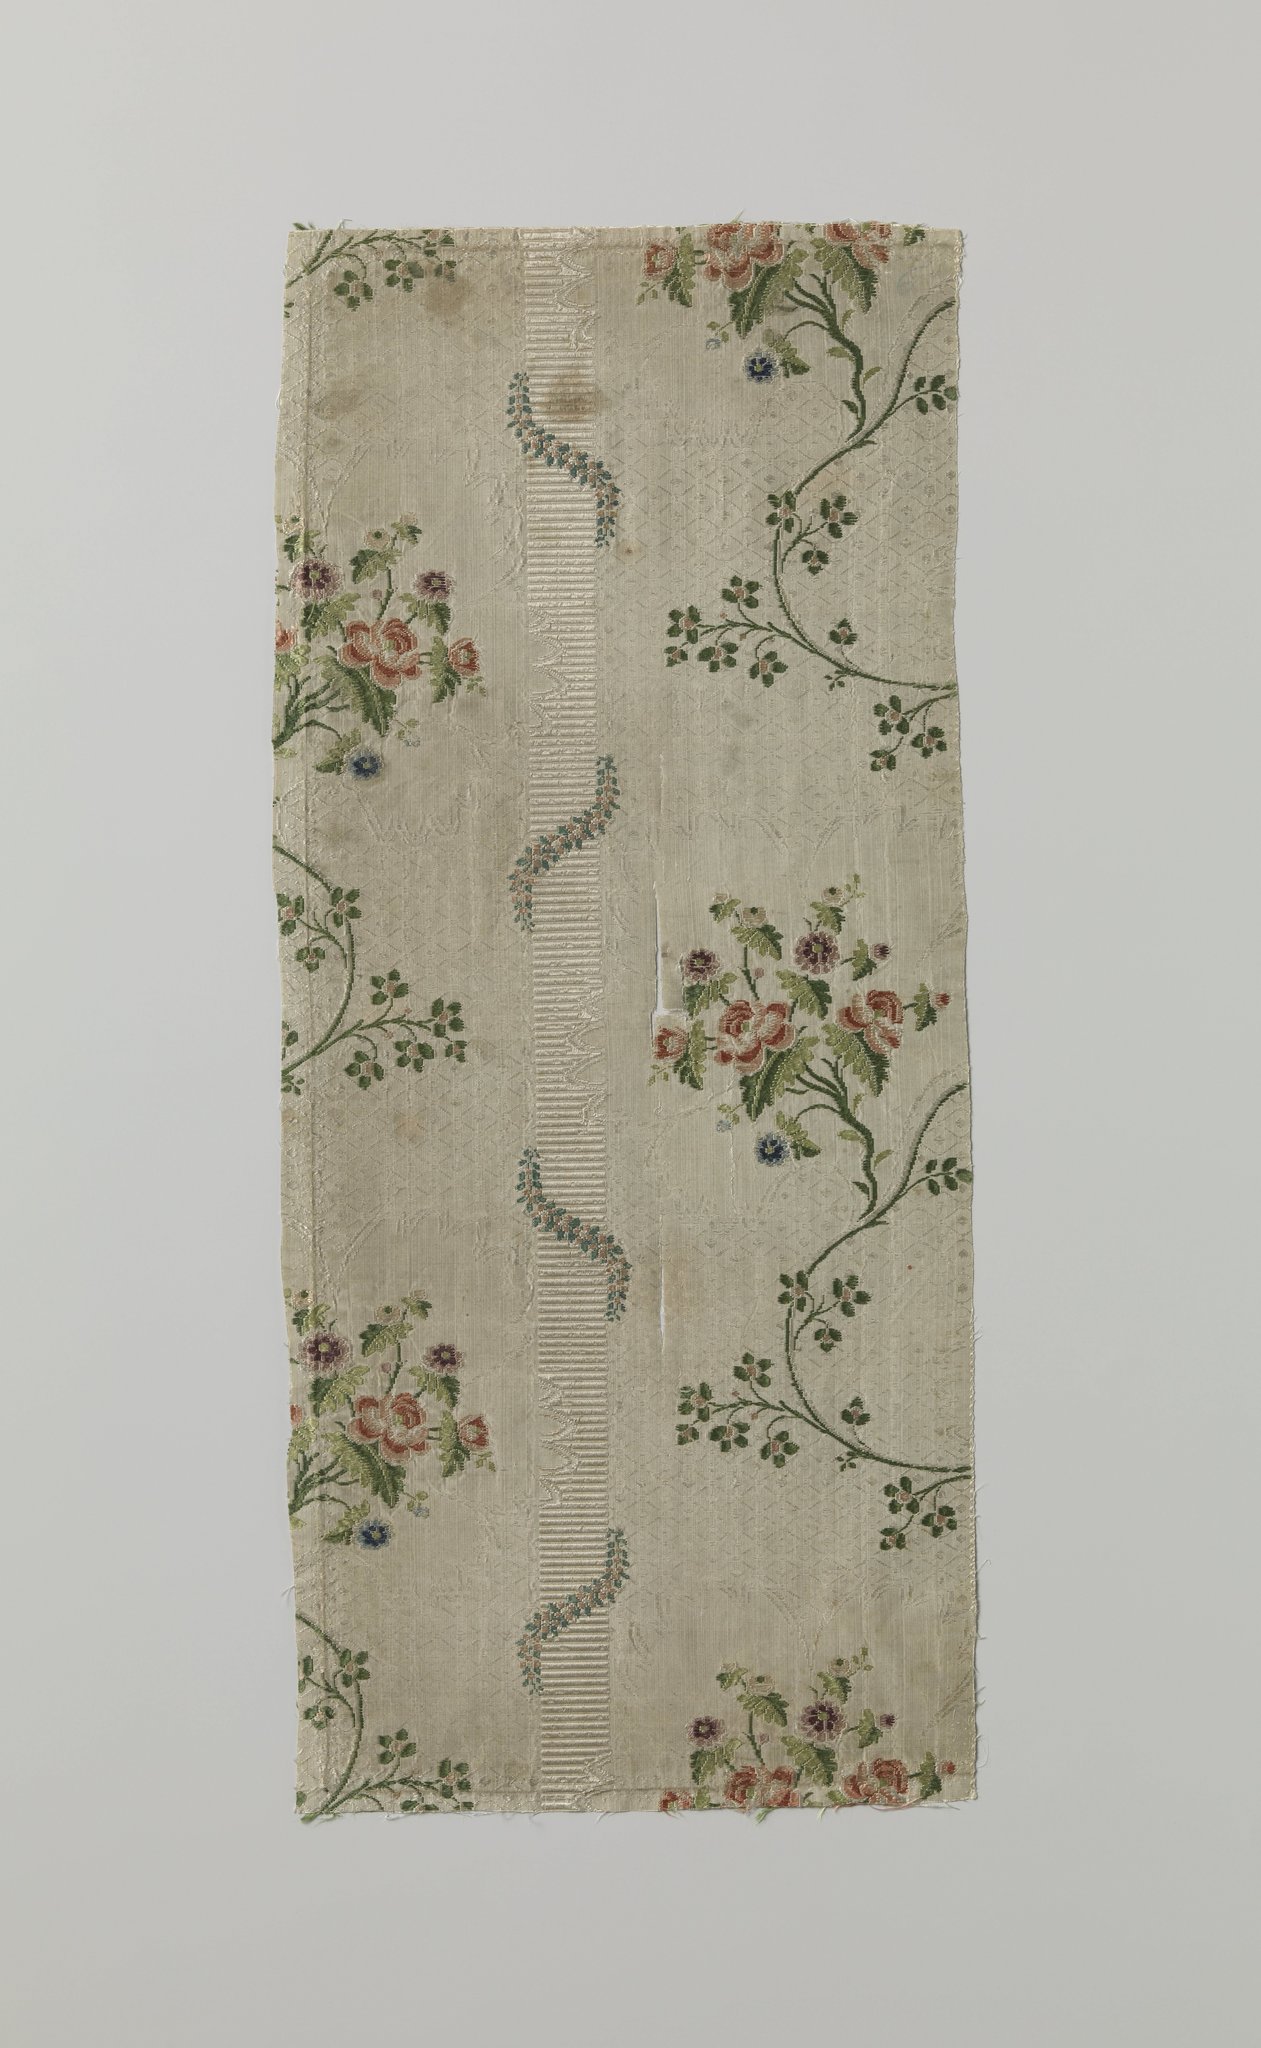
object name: fragment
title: Fragment veelkleurige gebrocheerde zijde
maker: Anonymous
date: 1750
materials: silk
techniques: brocade, gadrooning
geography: france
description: Een fragment zijdeweefsel. Een witte grond heeft een wit geruit patroon met stippen in de ruiten, horizontaal gestreepte banden waar omheen een gekleurde bloemslinger en witte omtrekken om veelkleurige bloemtakken.